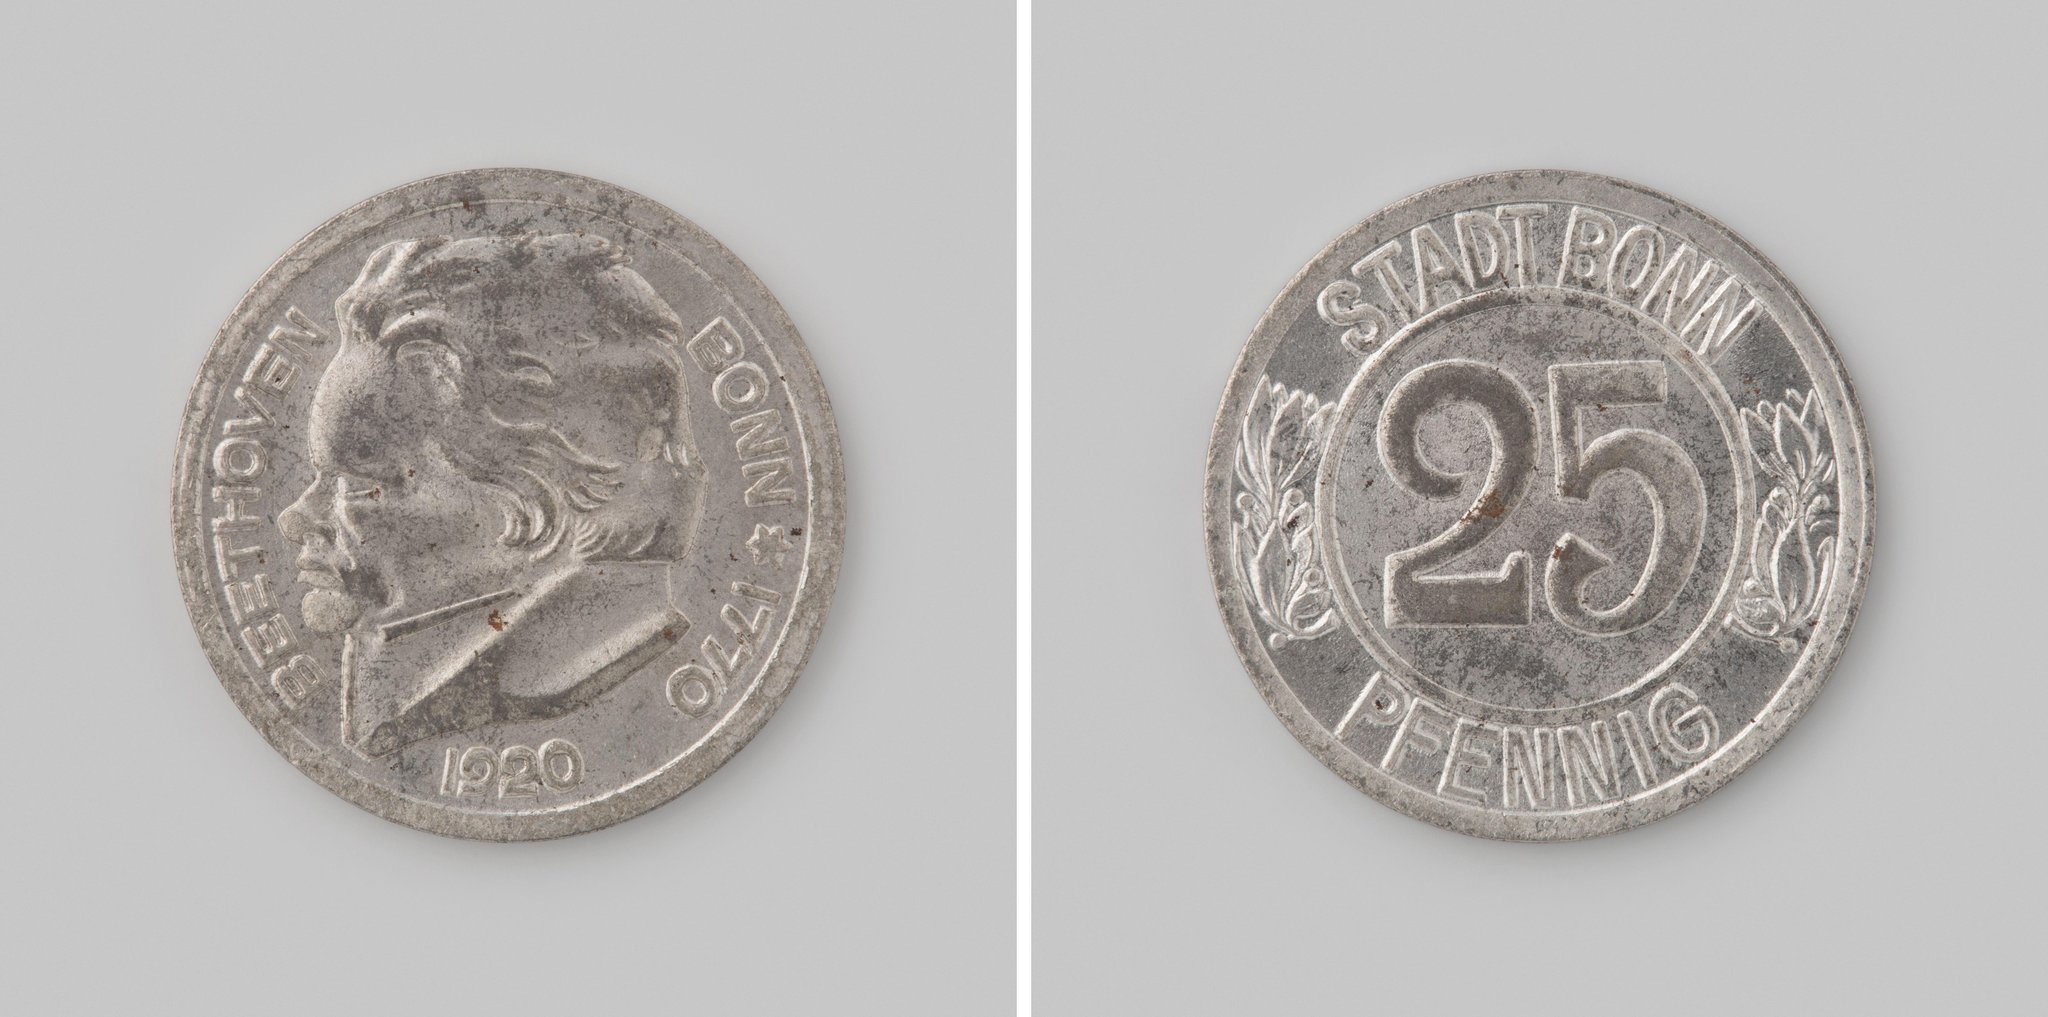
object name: siege coin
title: Duitsland, stadt Bonn, 25 pfennig, 1920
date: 1920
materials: aluminum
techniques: striking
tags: amsterdam, alexander johannes jacobus philippus haas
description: Aluminium noodmunt. Voorzijde: hoofd van Beethoven naar links. Plaatsaanduiding en jaartal als omschrift. Keerzijde: waarde-aanduiding in twee regels. Gladde rand.